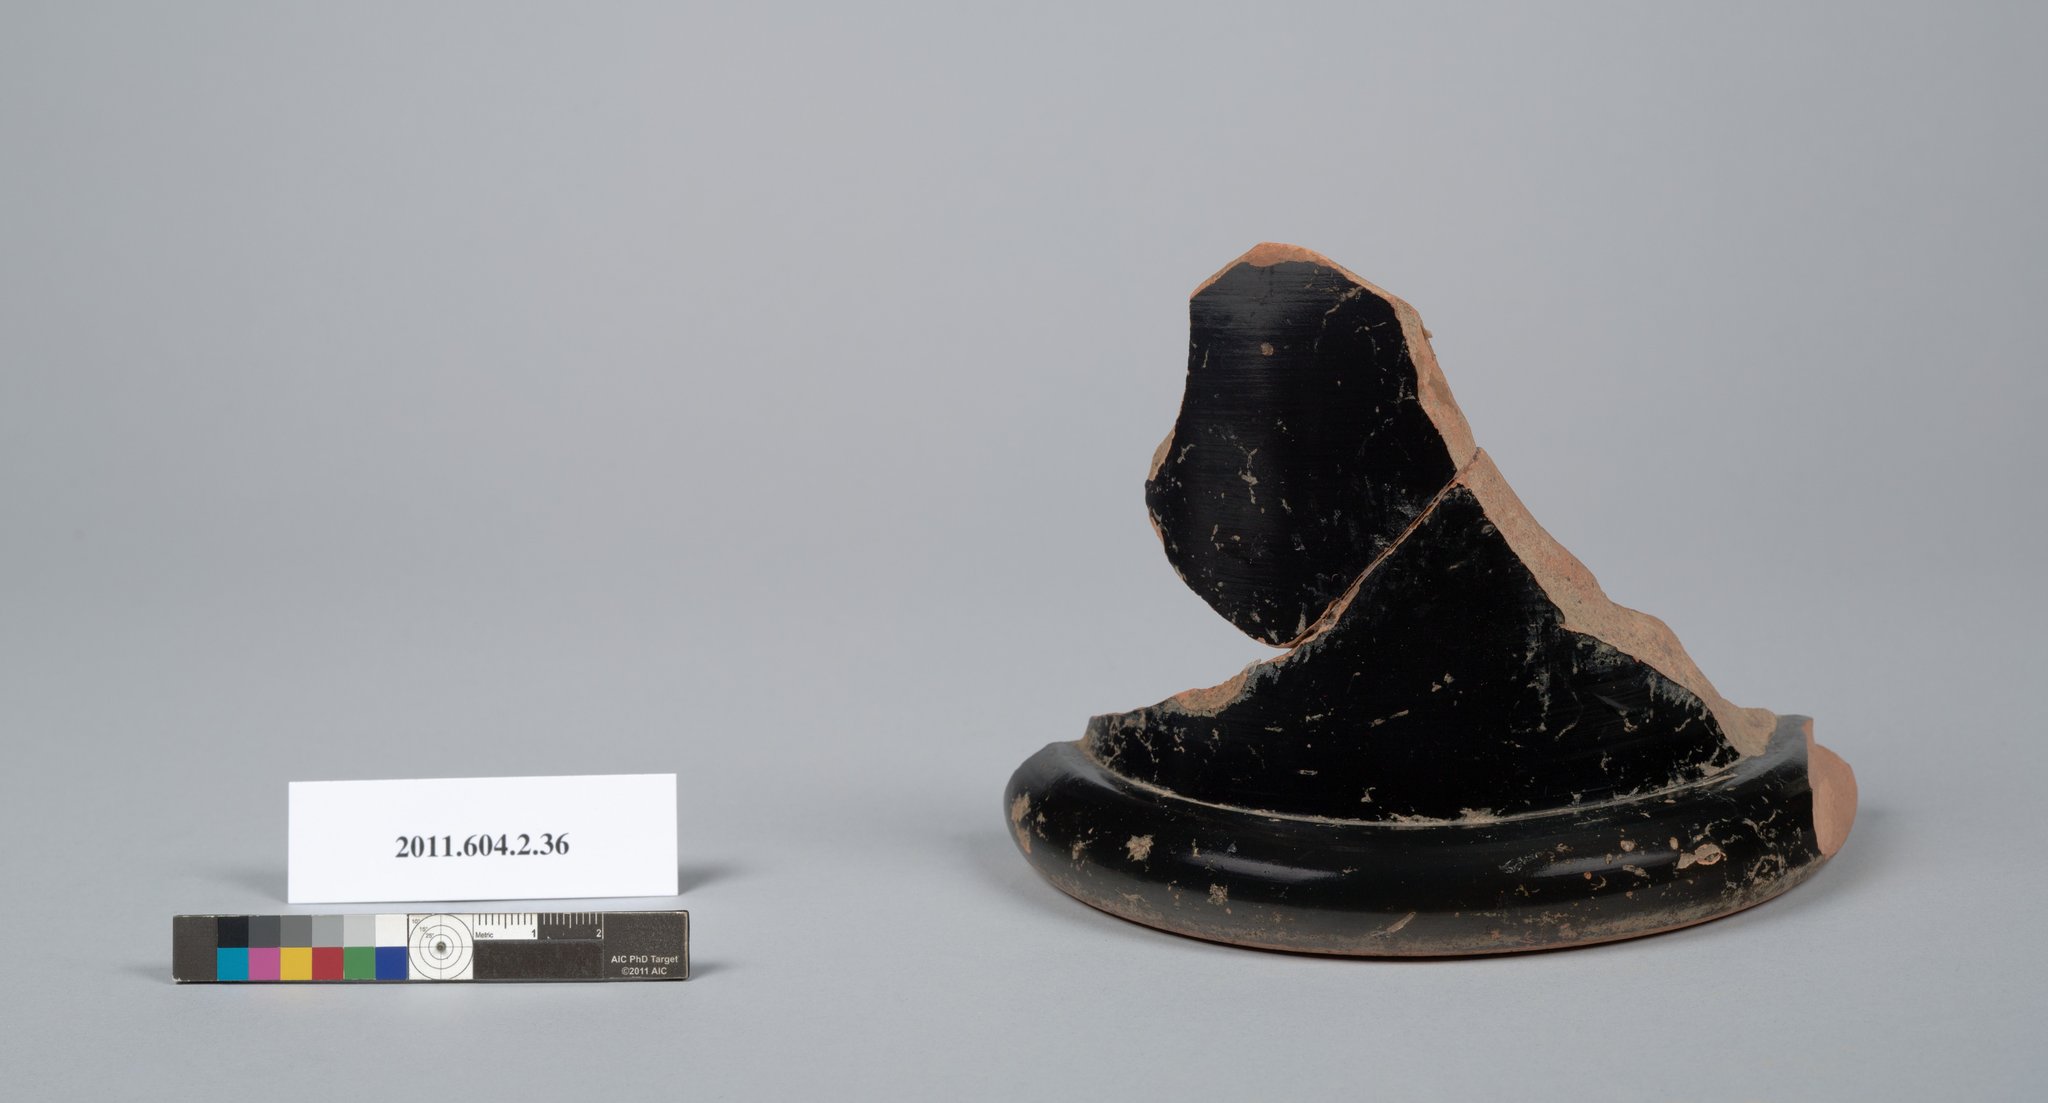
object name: psykter fragment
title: Terracotta fragment of a psykter (vase for cooling wine)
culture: greek, attic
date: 534-468 BCE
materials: terracotta